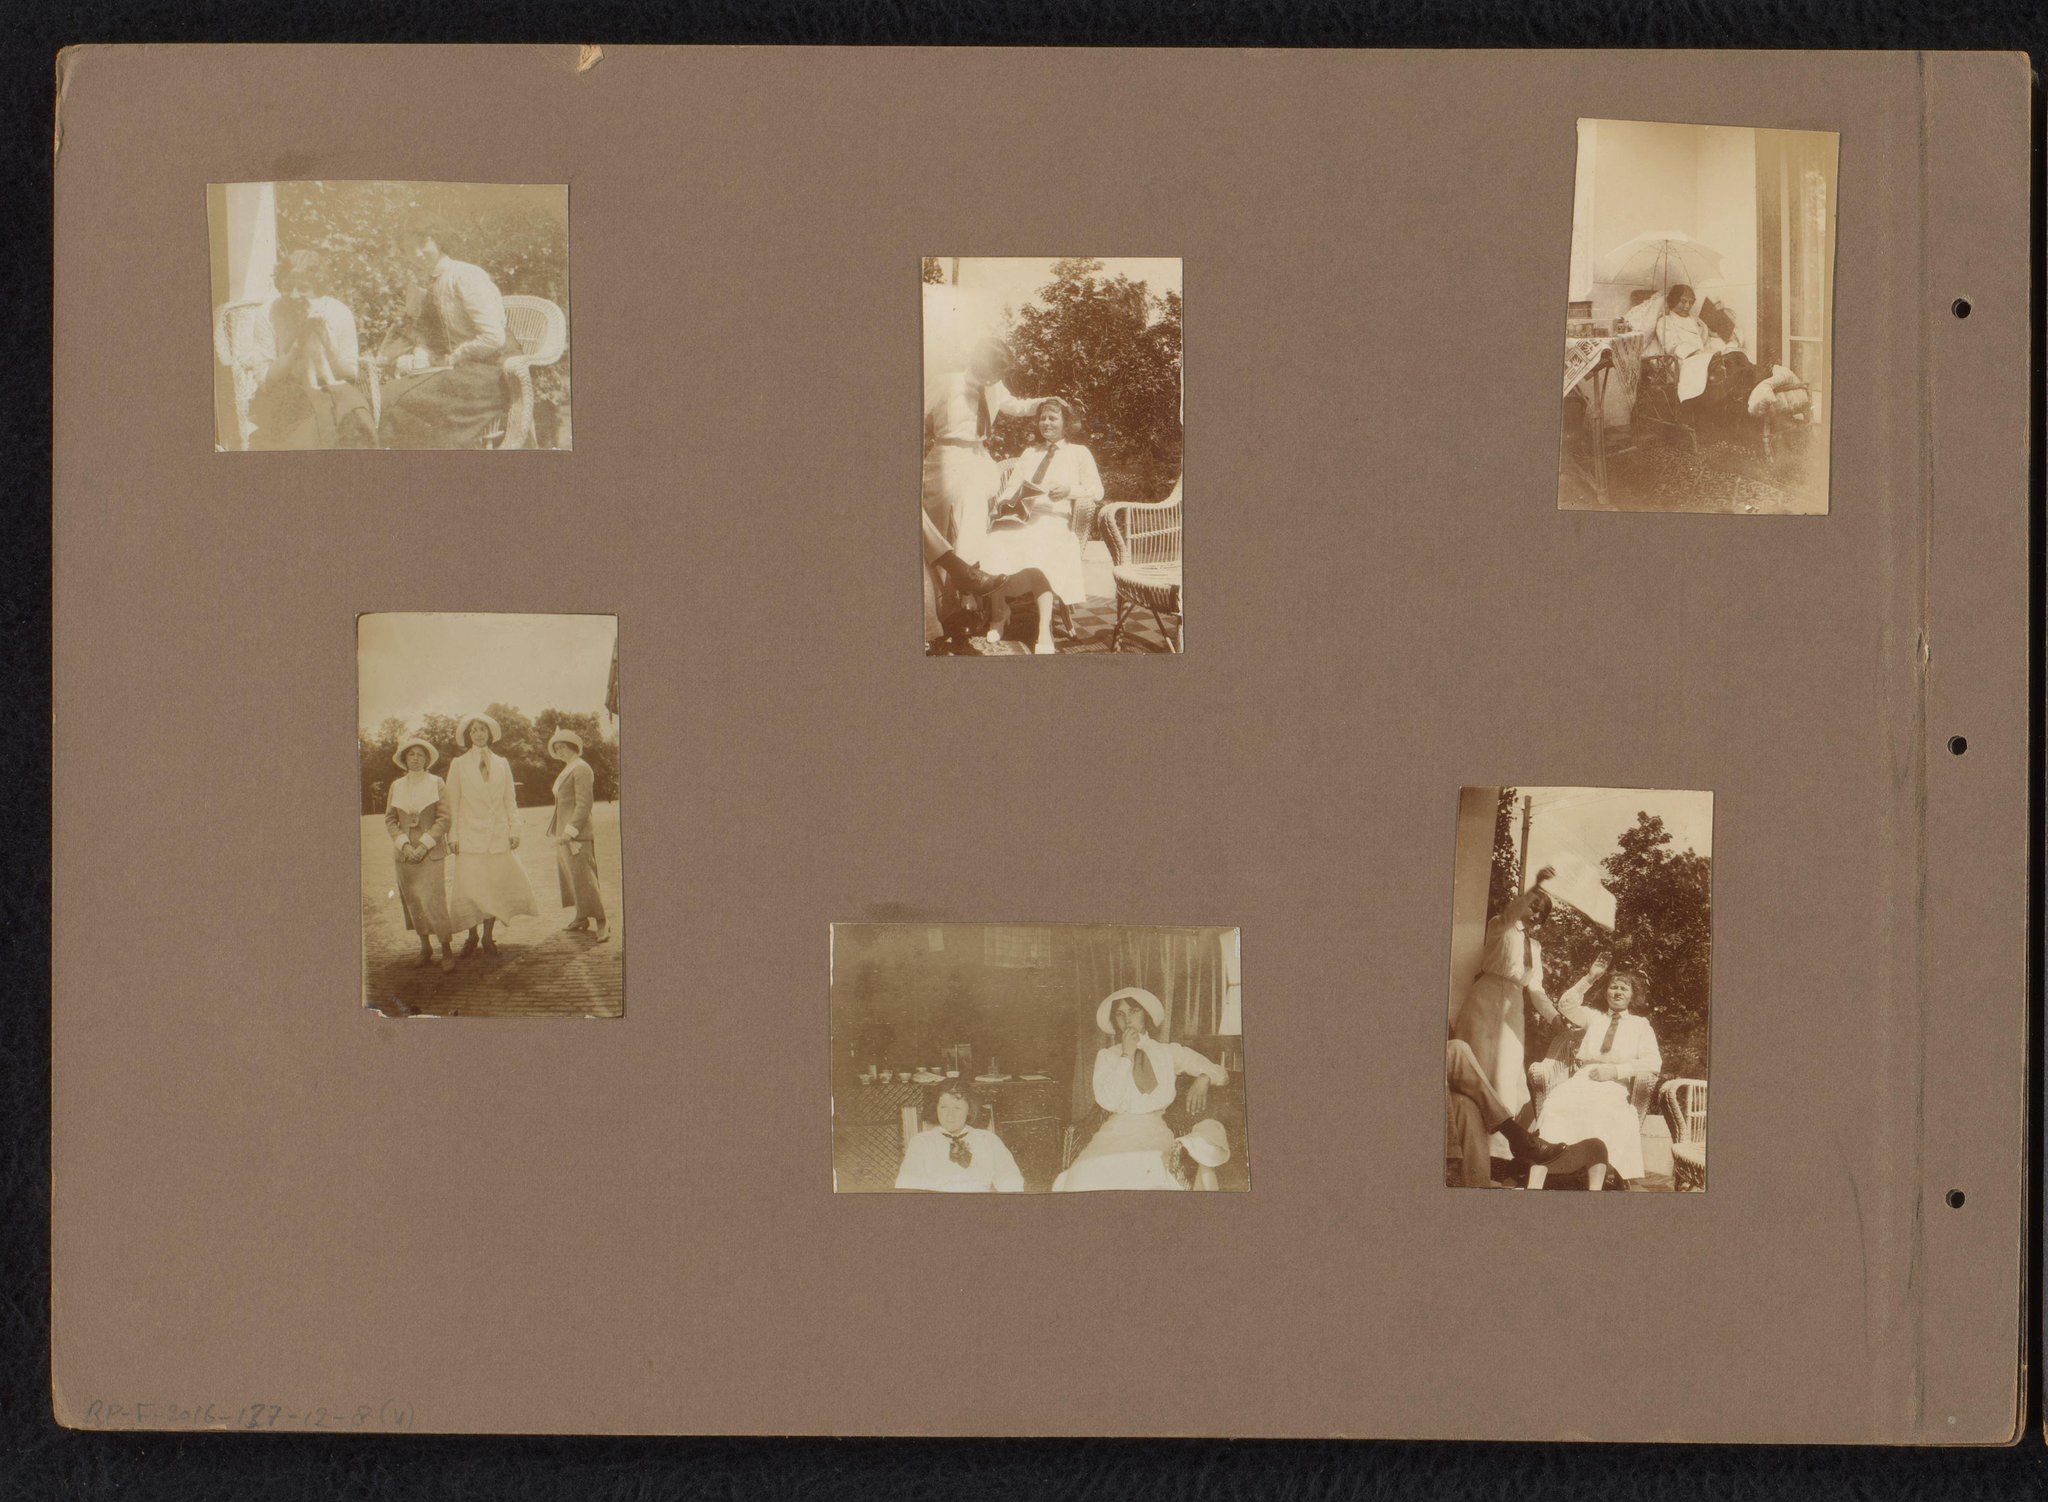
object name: album leaf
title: Gezin Onnen in een tuin bij een woonhuis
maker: carolina frederika onnen (lien/loen)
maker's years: 1896-1983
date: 1911-1912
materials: paper, cardboard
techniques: collodion silver print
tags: batavia, emilie albertina onnen (milly), amsterdam, carolina frederika onnen (lien/loen), family life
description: Deze foto's zijn onderdeel van een album.